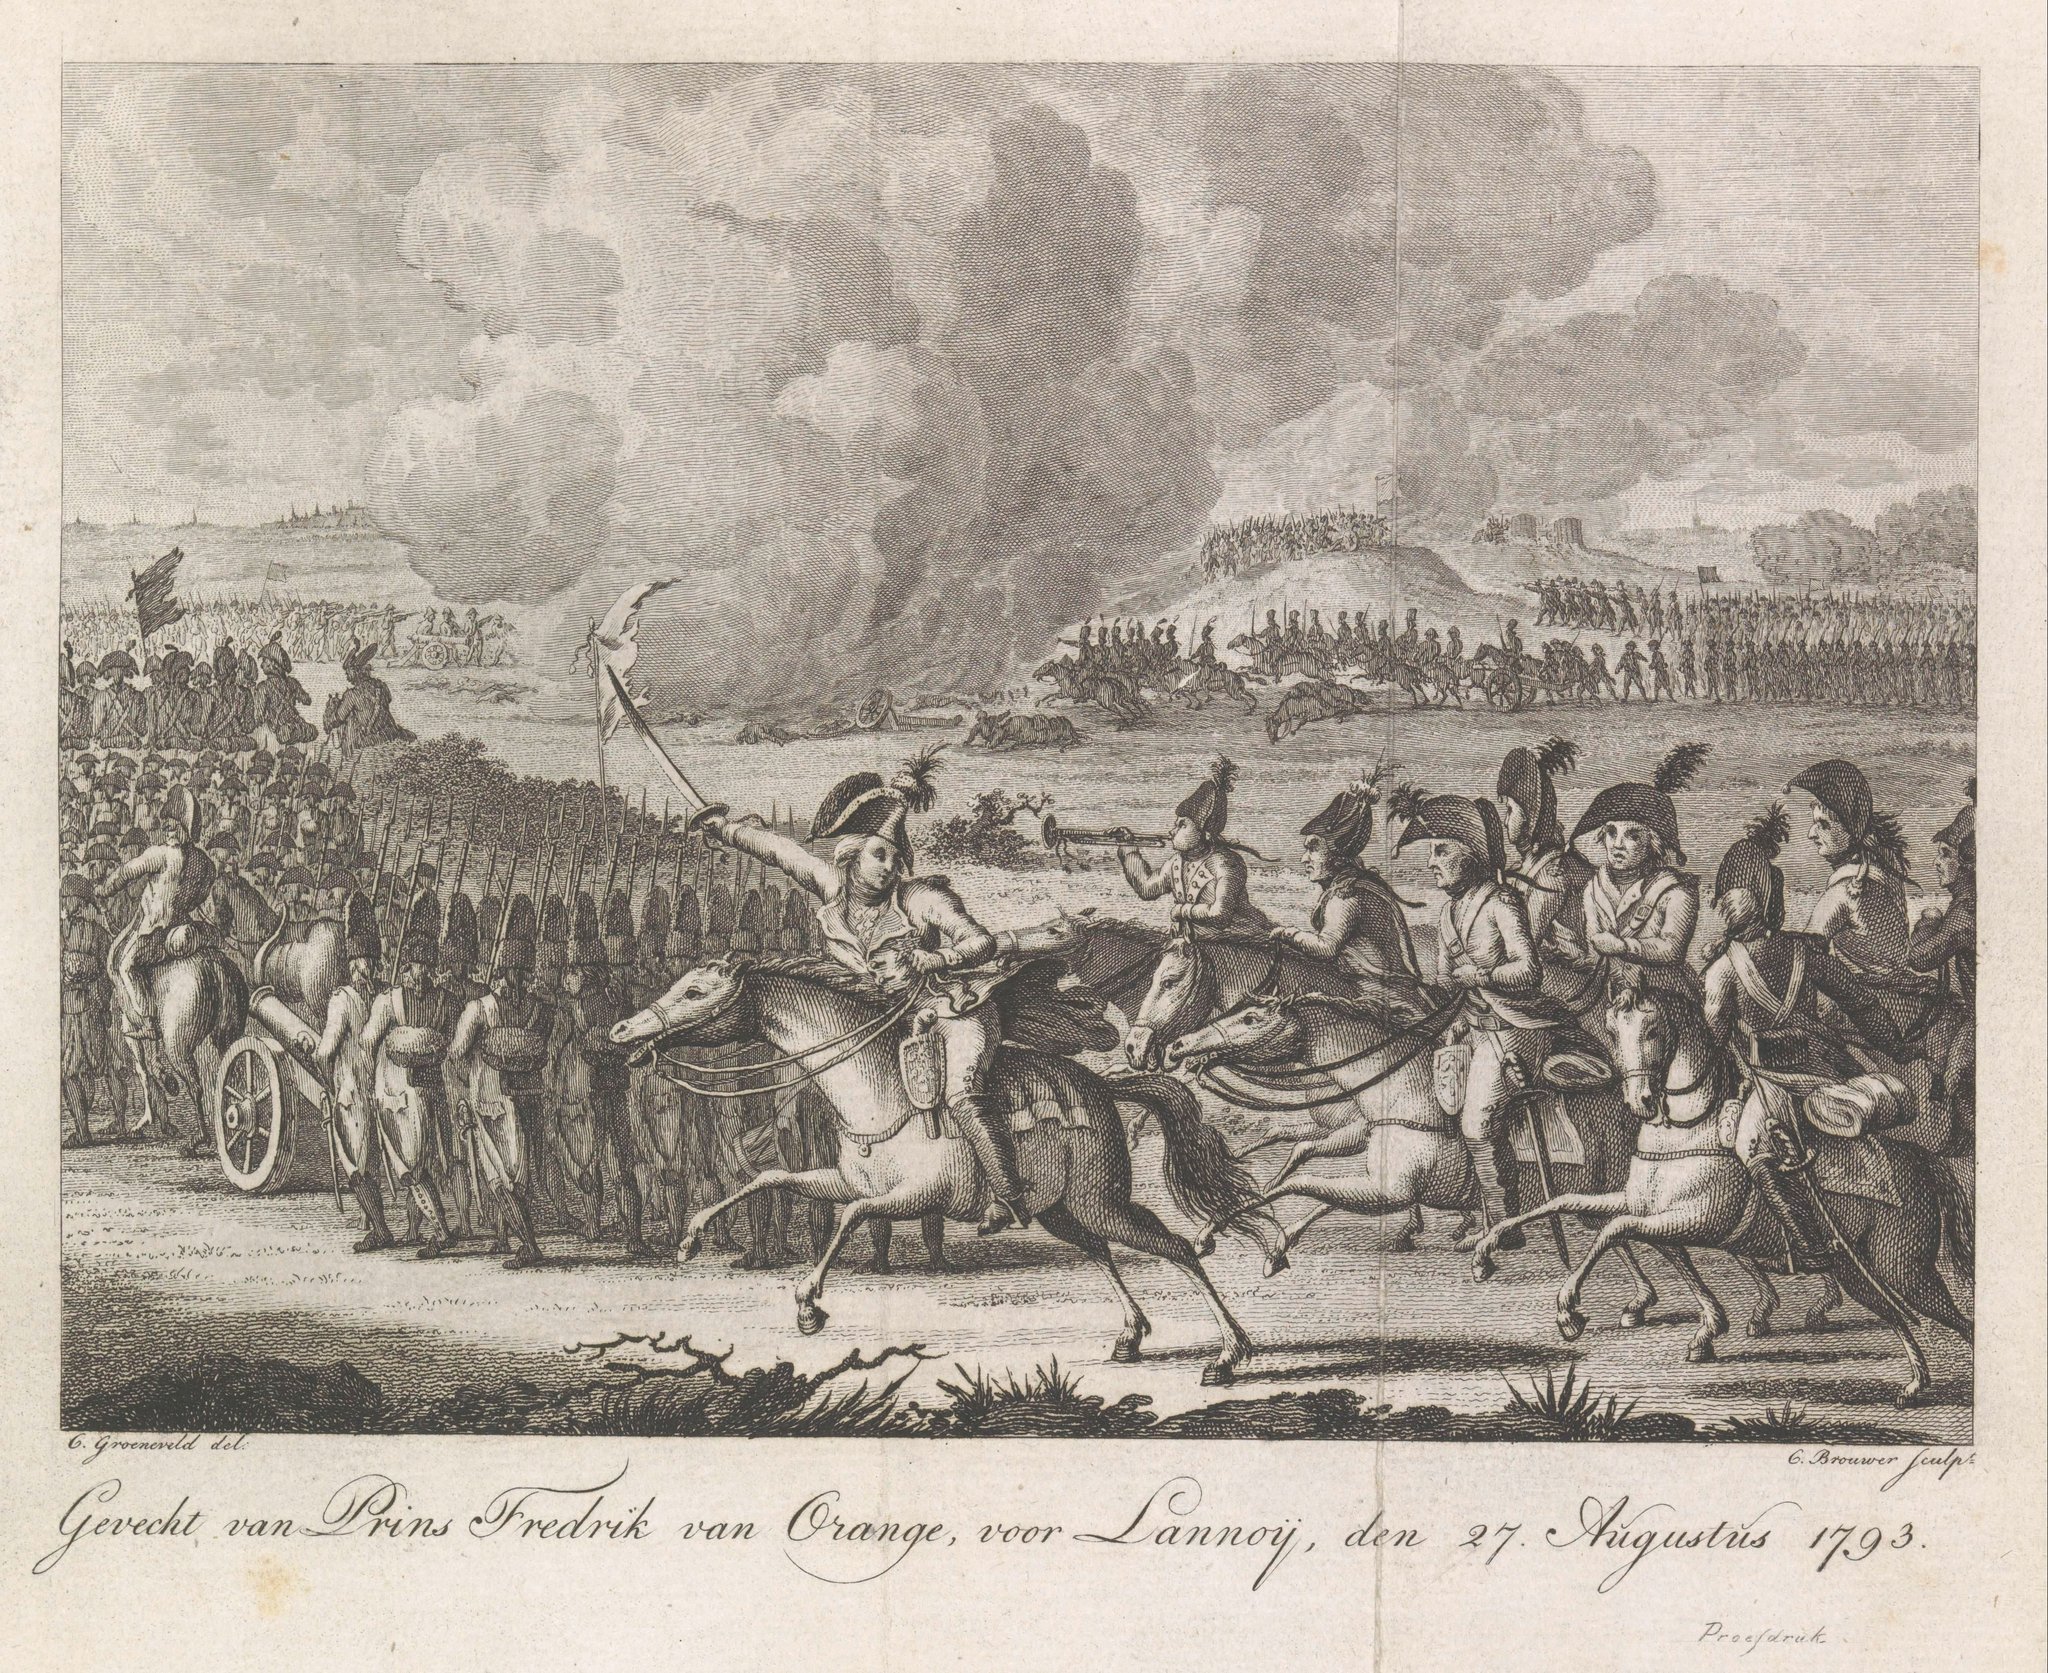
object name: print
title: Prins Willem George Frederik in de slag bij Lannoy, 1793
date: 1802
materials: paper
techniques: engraving, etching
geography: netherlands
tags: the hague, willem george frederik (prins van oranje-nassau), battle (+ land forces)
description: Willem George Frederik, prins van Oranje-Nassau, leidt de Nederlandse troepen tegen de Fransen in de slag bij Lannoy, 27 augustus 1793. Illustratie in het vierdelige Leven van Willem George Fredrik (1802-1803).